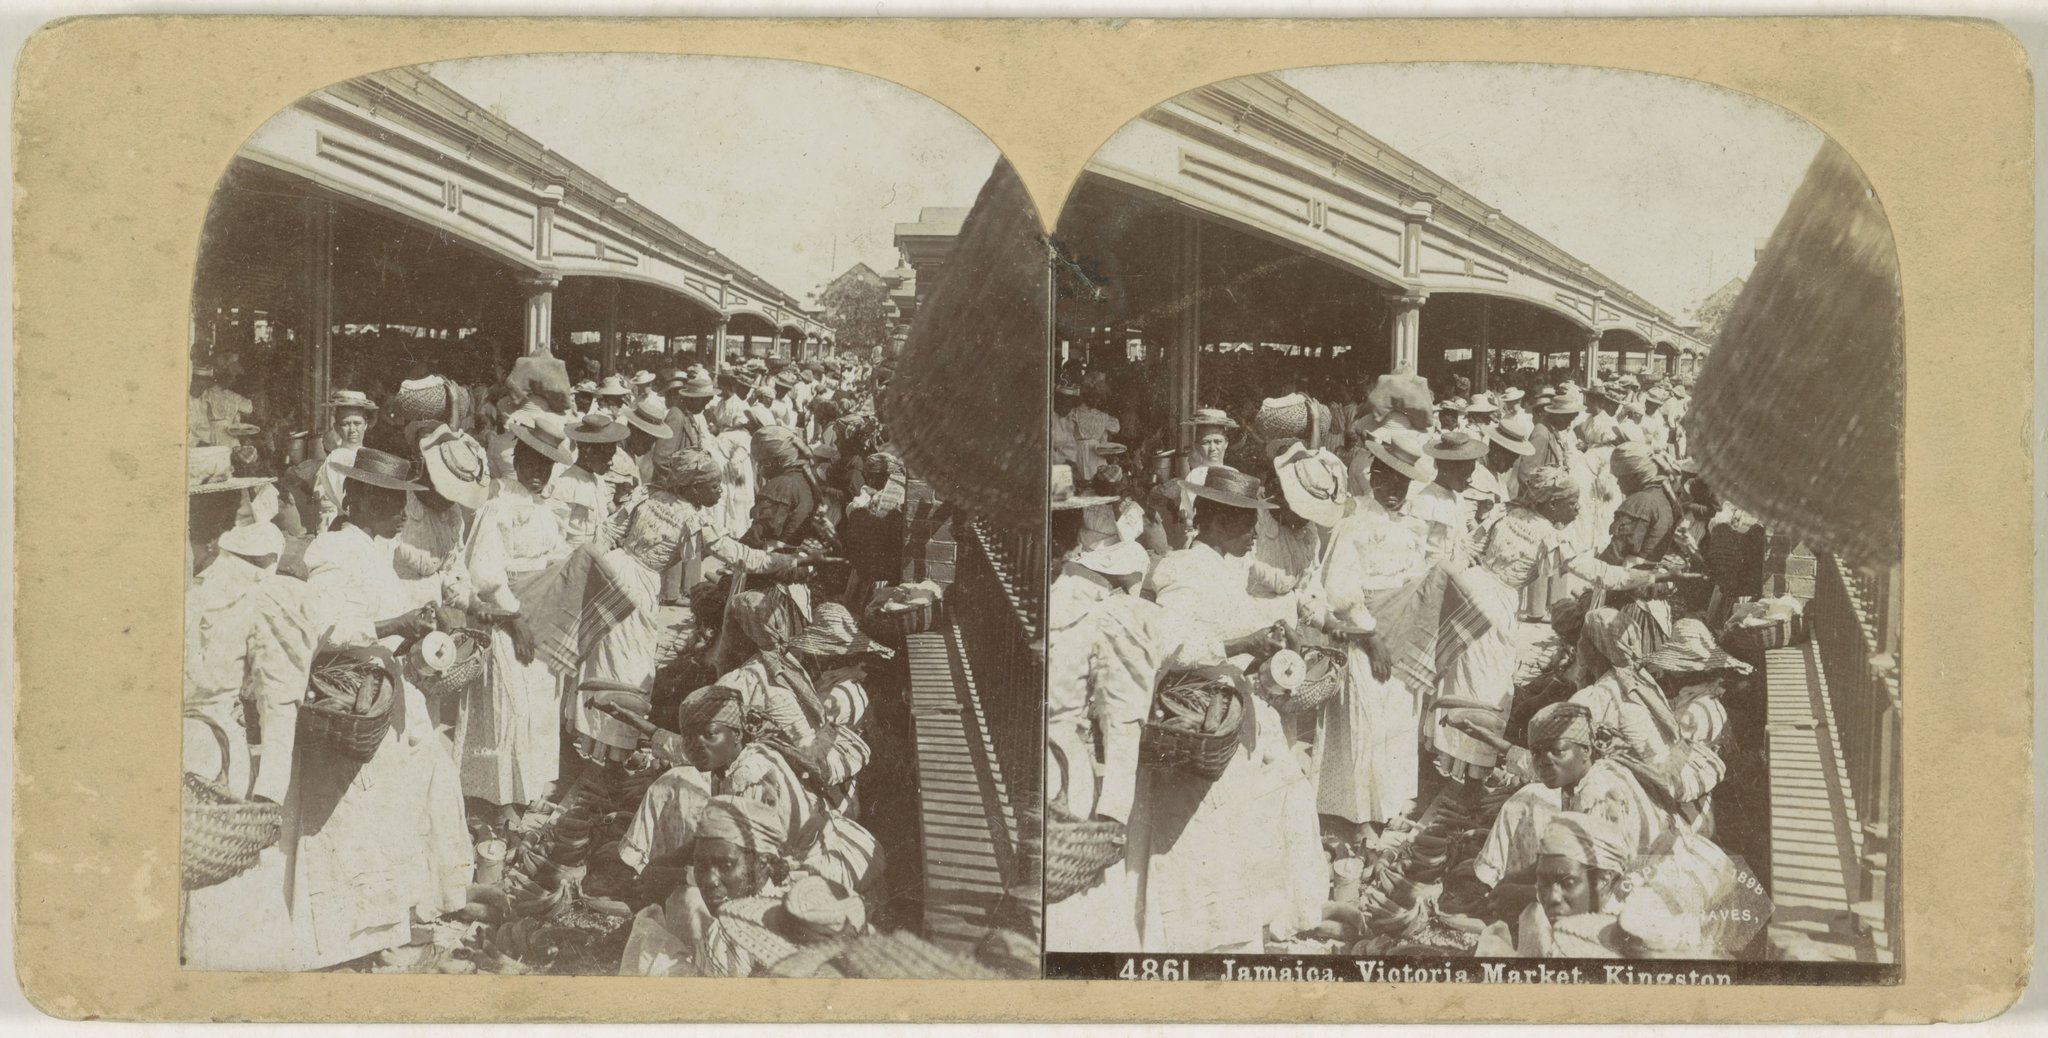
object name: stereograph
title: Jamaica. Victoria Market. Kingston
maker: carleton harlow graves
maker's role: fotograaf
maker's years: 1867-1943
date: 1898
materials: paper, cardboard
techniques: gelatin silver print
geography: kingston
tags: marketing, shopping (~ household management)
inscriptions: number: ‘441’, copyright notice: ‘COPYRIGHT 1898/ BY C. H. GRAVES,/ [?]’, number: ‘4861’